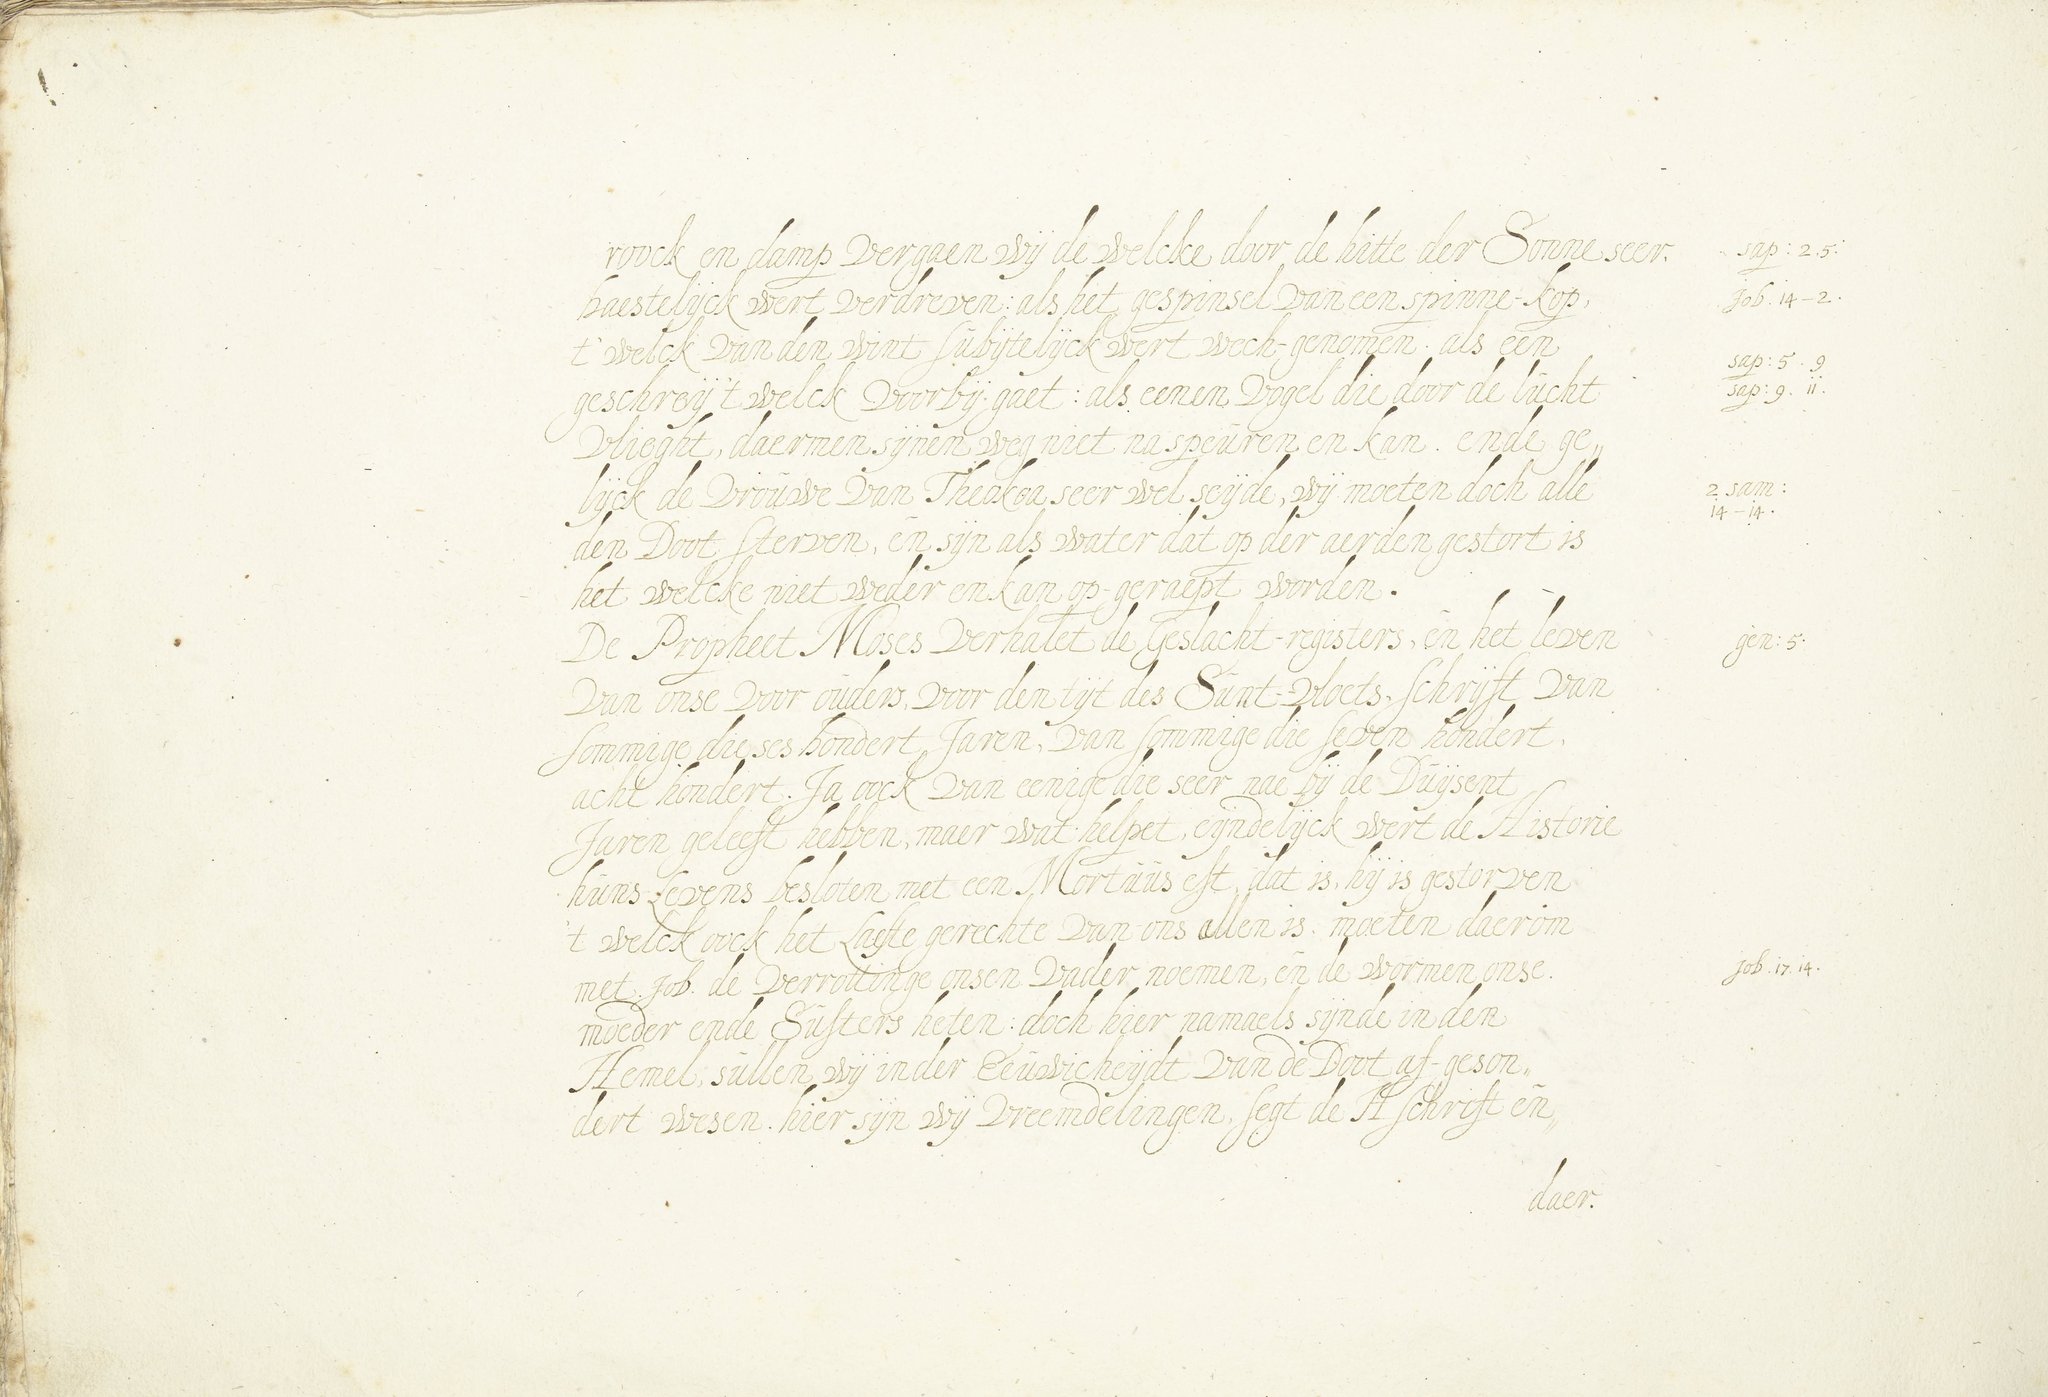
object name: text sheet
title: Preek over vanitasthema's (deel 6)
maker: gesina ter borch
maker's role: draughtsman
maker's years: 1633-1690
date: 1660-1687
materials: ink, paper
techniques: writing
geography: zwolle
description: Preek of overpeinzing die Gesina waarschijnlijk ergens gehoord of gelezen had. In de marges staan de vele Bijbelse bronnen waarop de tekst gebaseerd is.